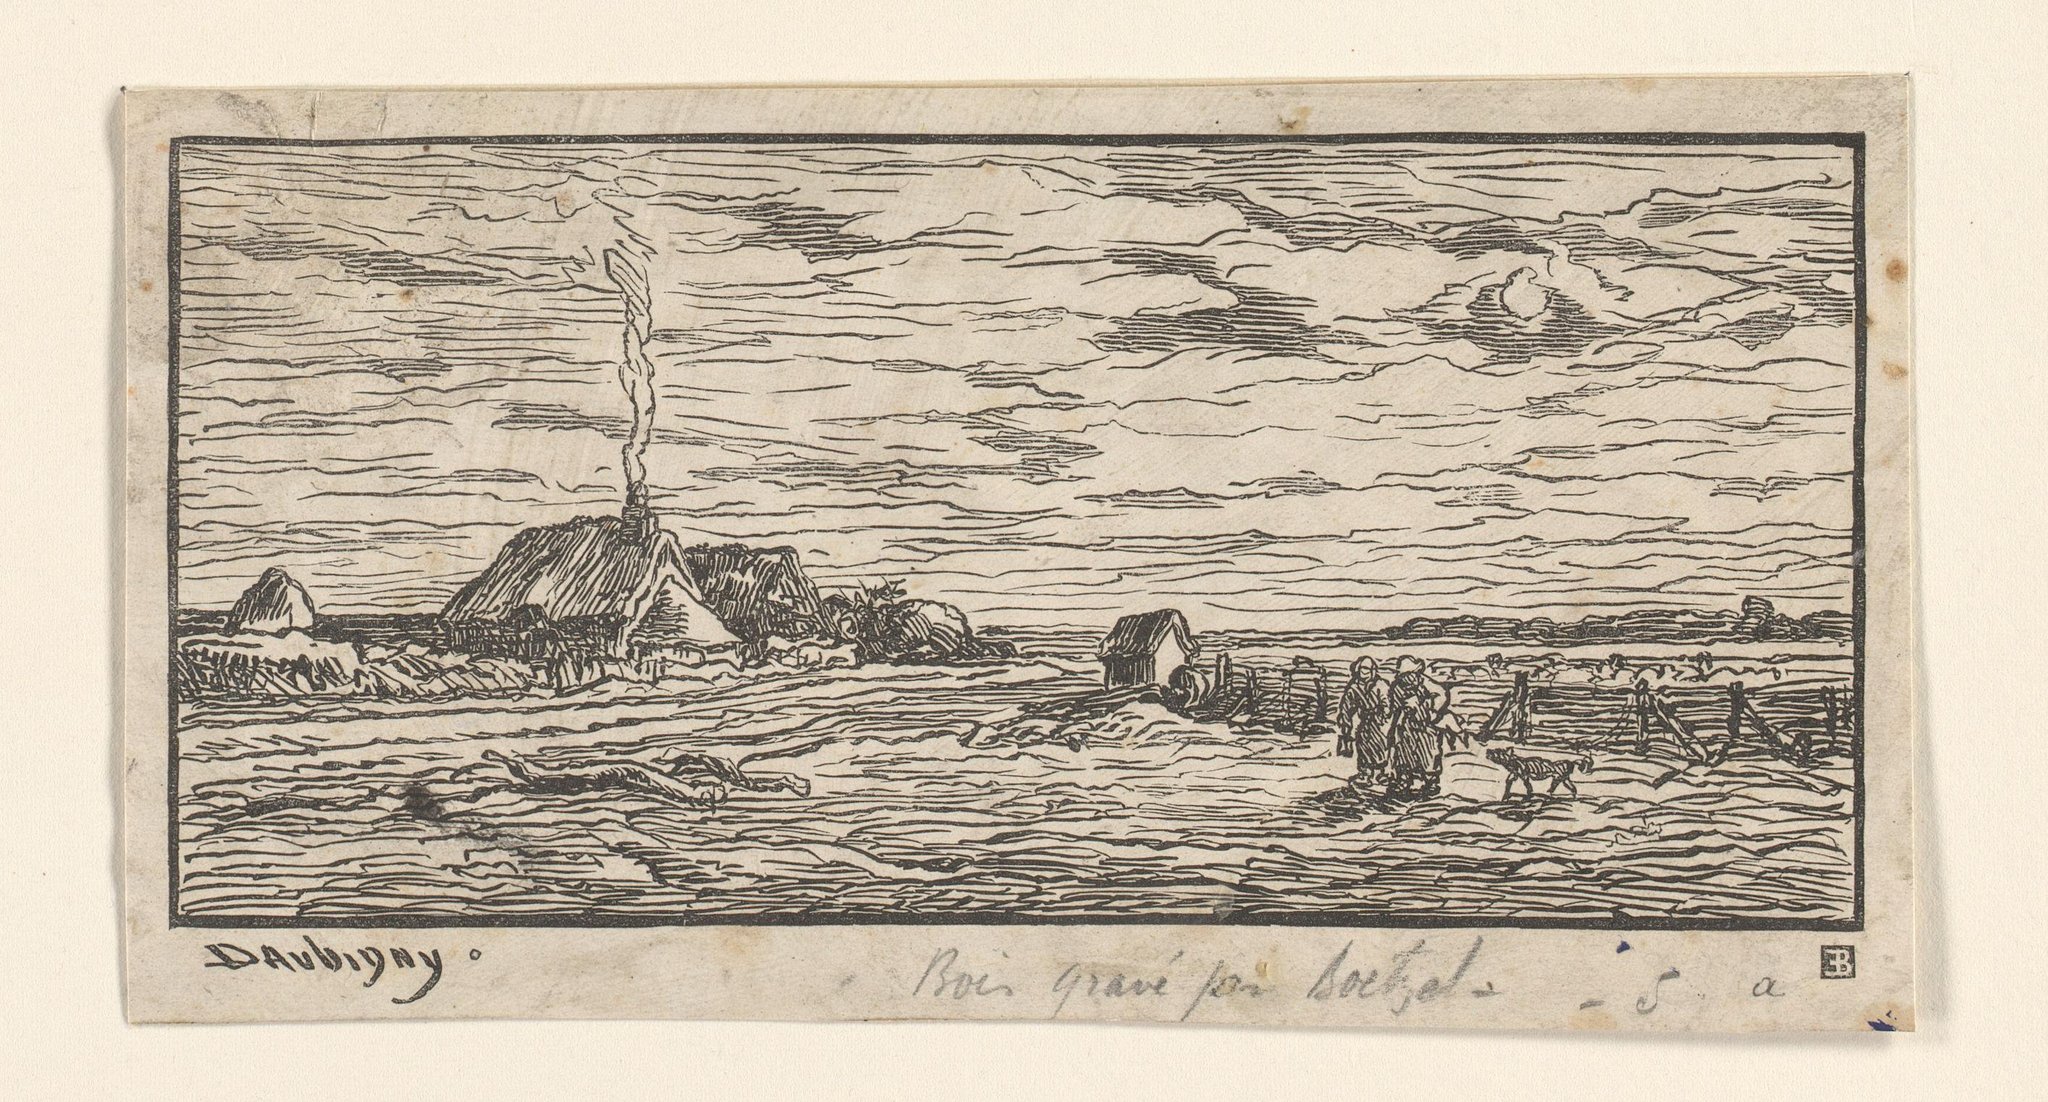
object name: print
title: Vlak landschap met boerderijen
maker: ernest boetzel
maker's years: 1830-1920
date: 1865-1920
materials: paper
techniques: engraving